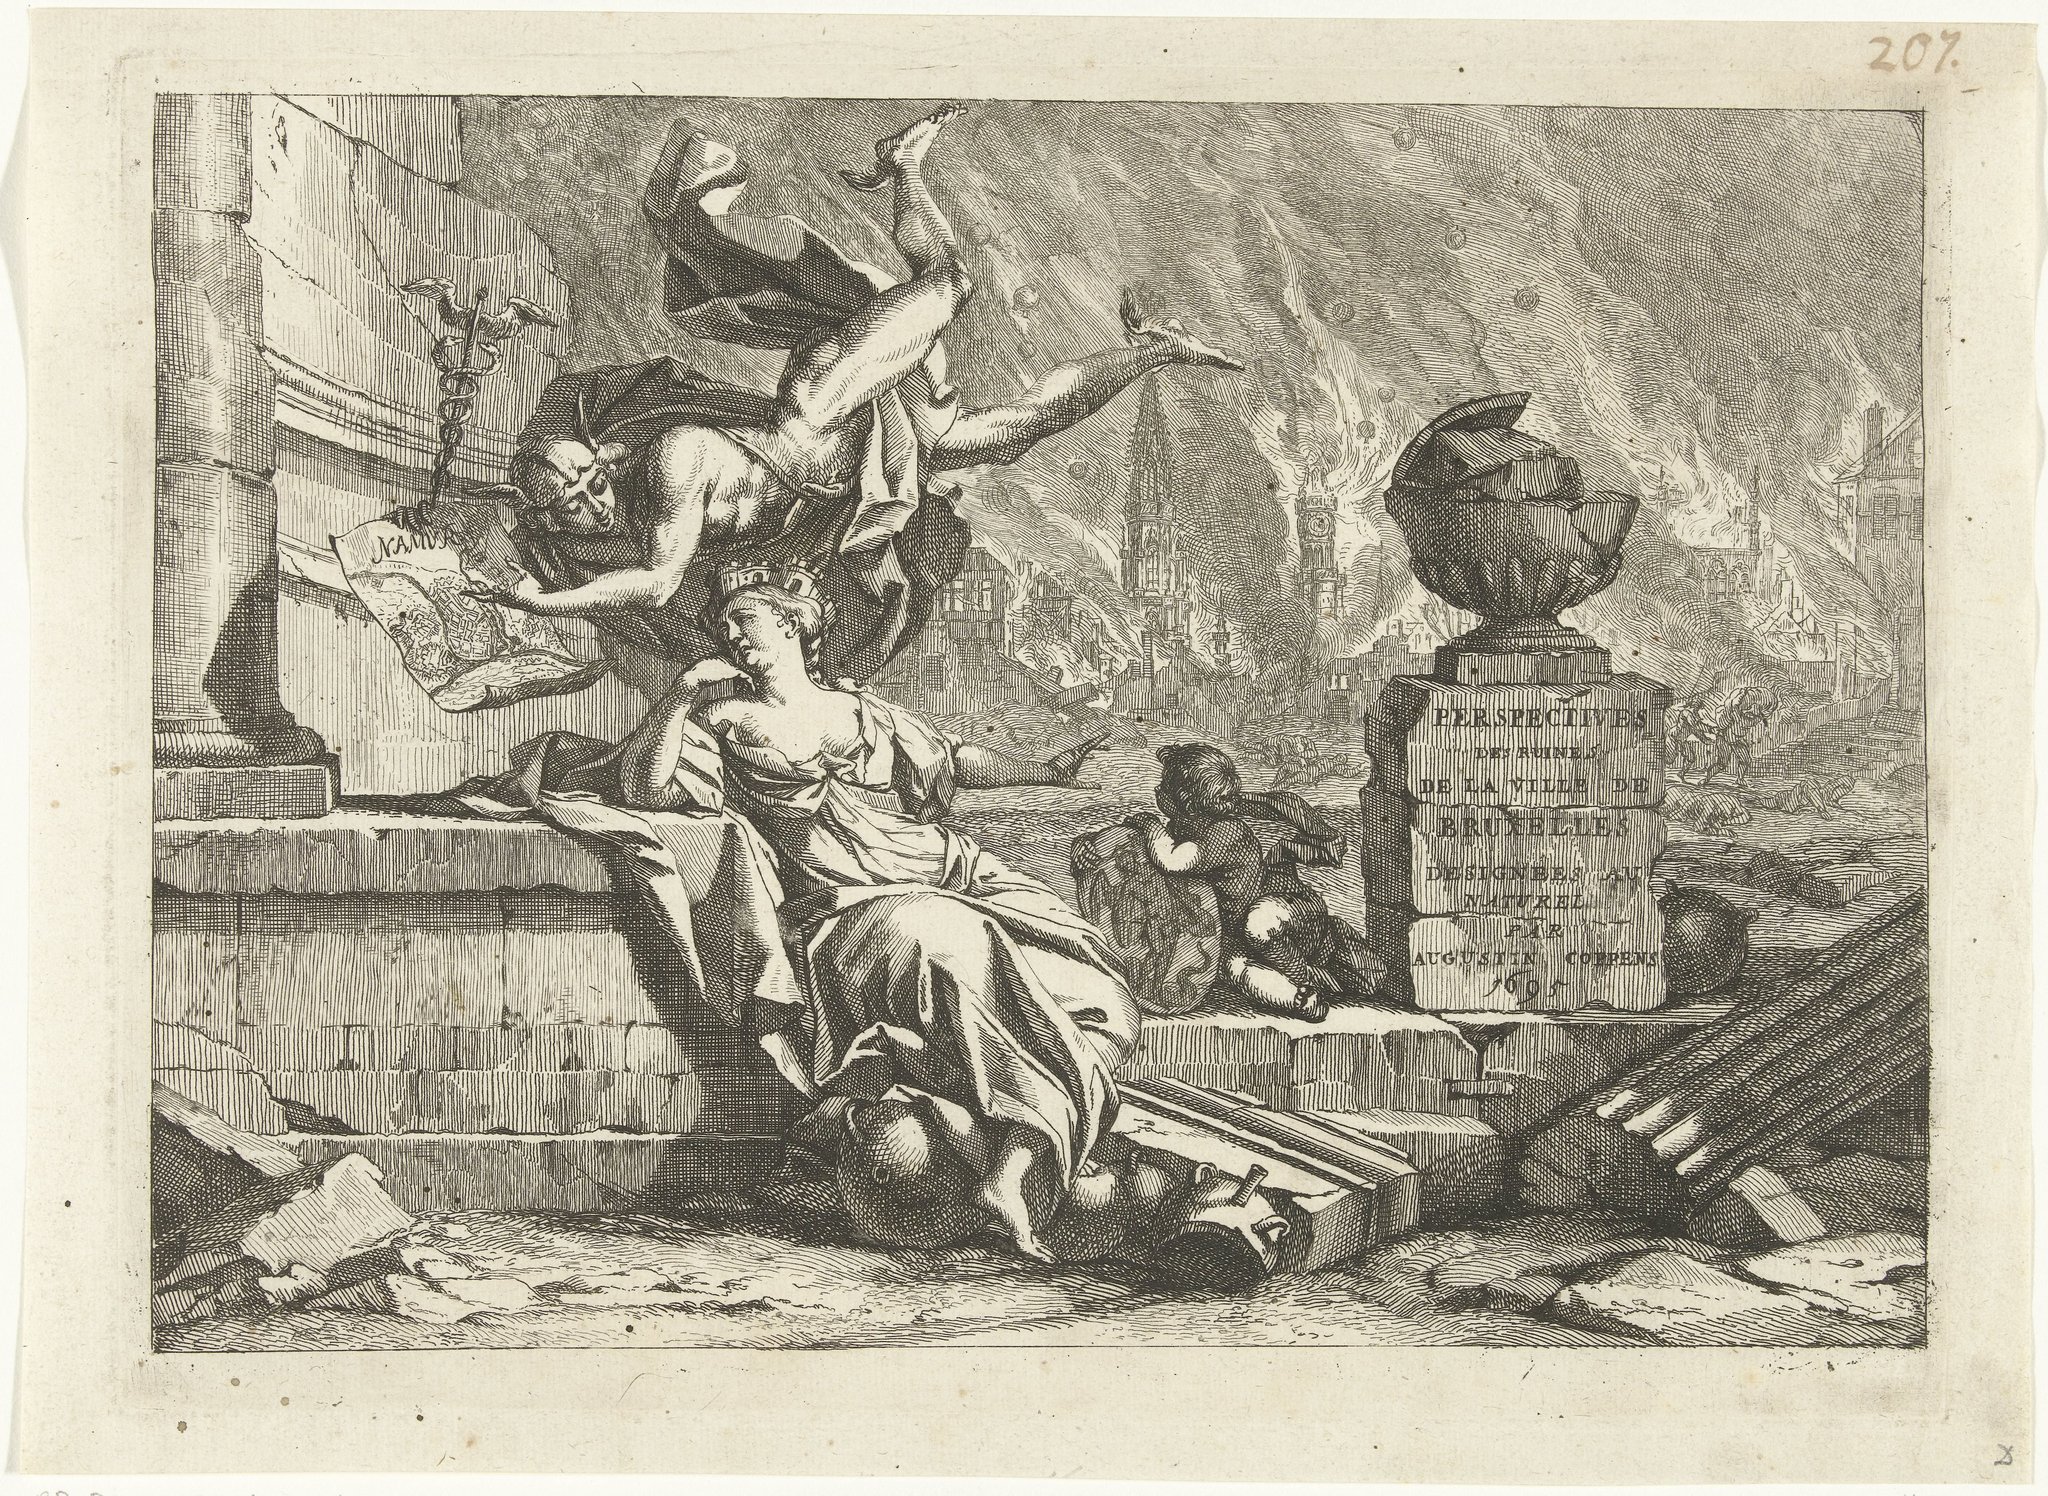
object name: titelprent, frontispice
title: Mercurius troost de Brusselse stedenmaagd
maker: augustin coppens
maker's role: print maker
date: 1695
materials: paper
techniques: etching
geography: brussels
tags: devastated, ruined place or city (~ warfare), brussels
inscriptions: collector's mark: Lugt 2228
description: Titelblad van een reeks van twaalf voorstellingen van de ruïnes van Brussel na het bombardement door de Franse maarschalk de Villeroy tussen 13-15 augustus 1695. In de voorstelling probeert Mercurius de stedenmaagd van Brussel te troosten met het nieuws van de verovering van Namen. Op de achtergrond de brandende stad.